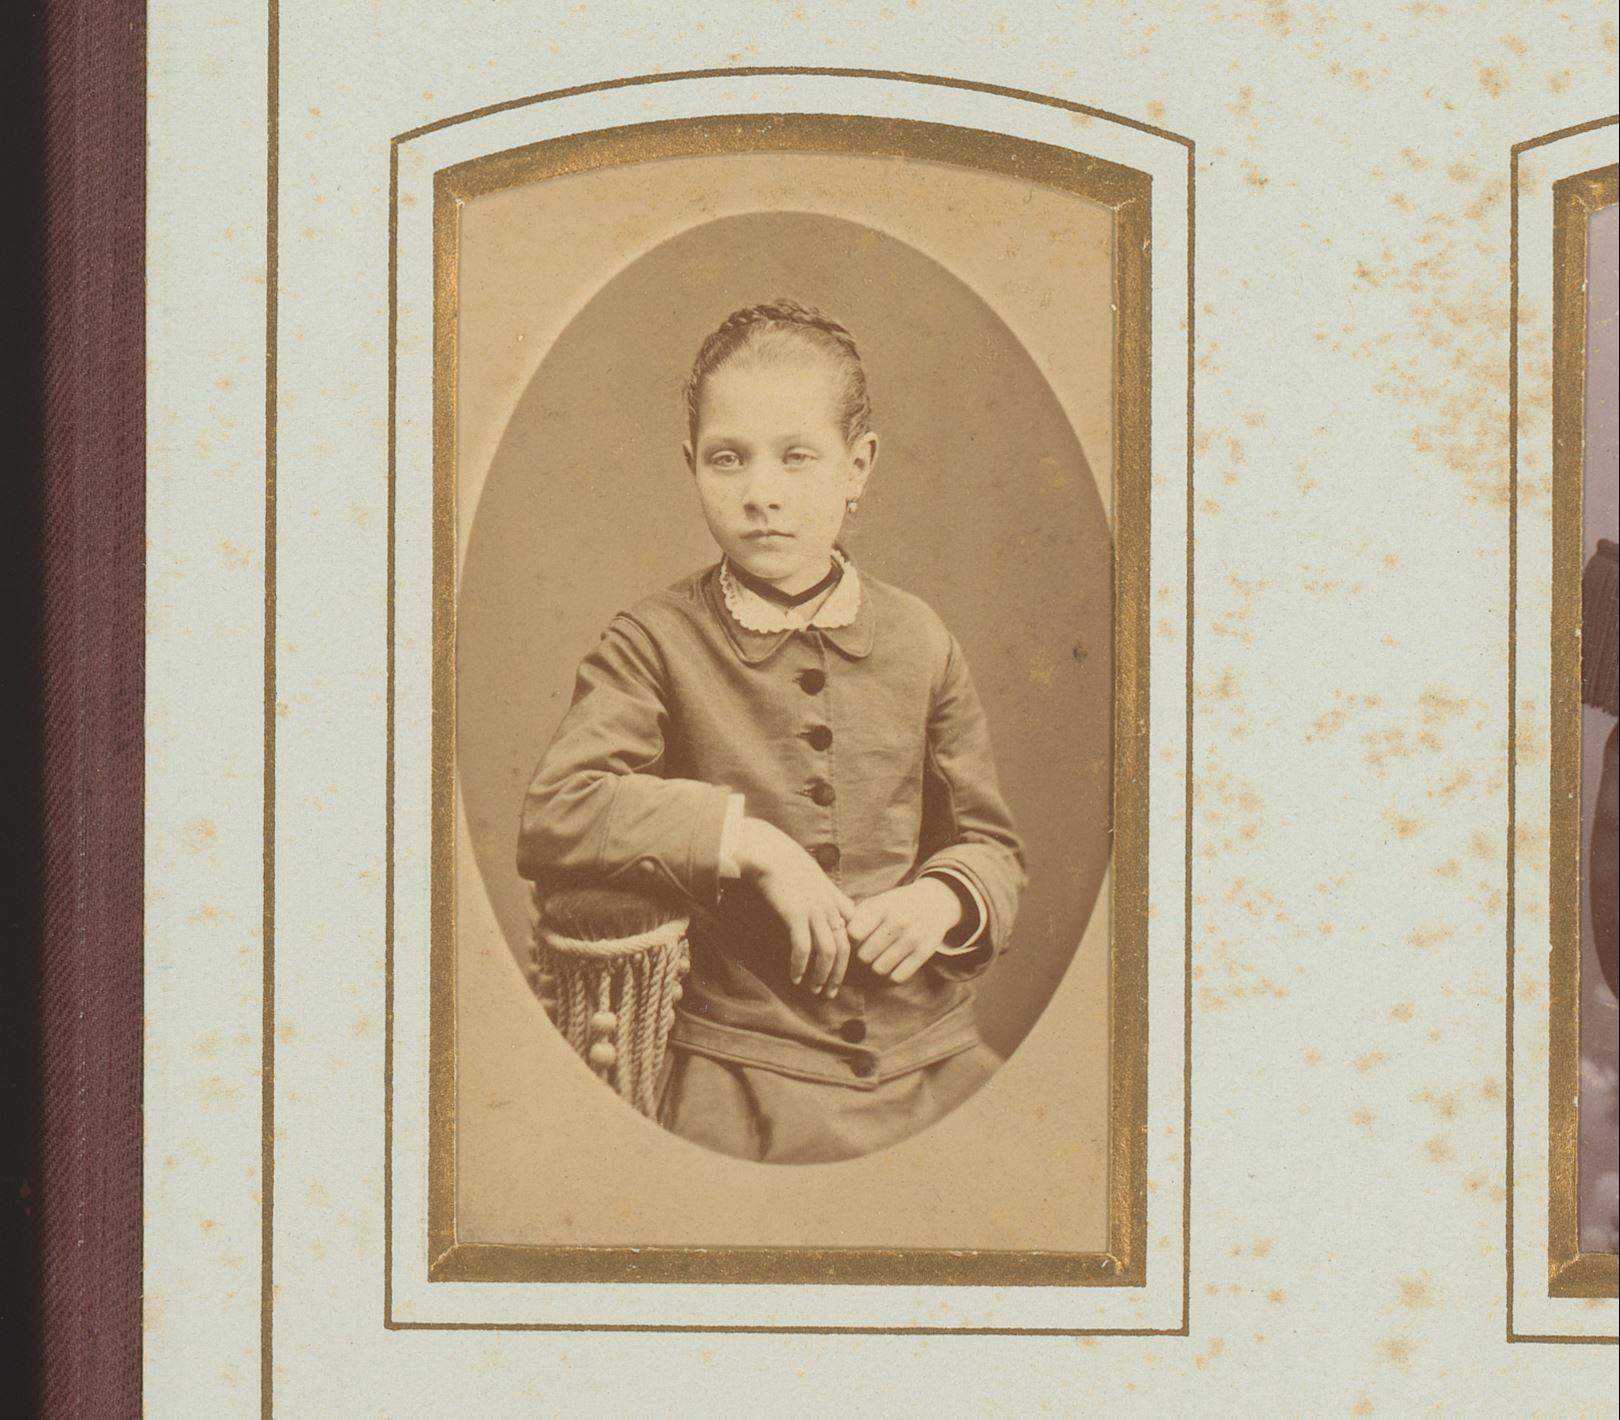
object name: photograph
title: Portret van een meisje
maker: Anonymous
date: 1860-1900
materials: cardboard, photographic support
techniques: albumen print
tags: girl (child between toddler and youth)